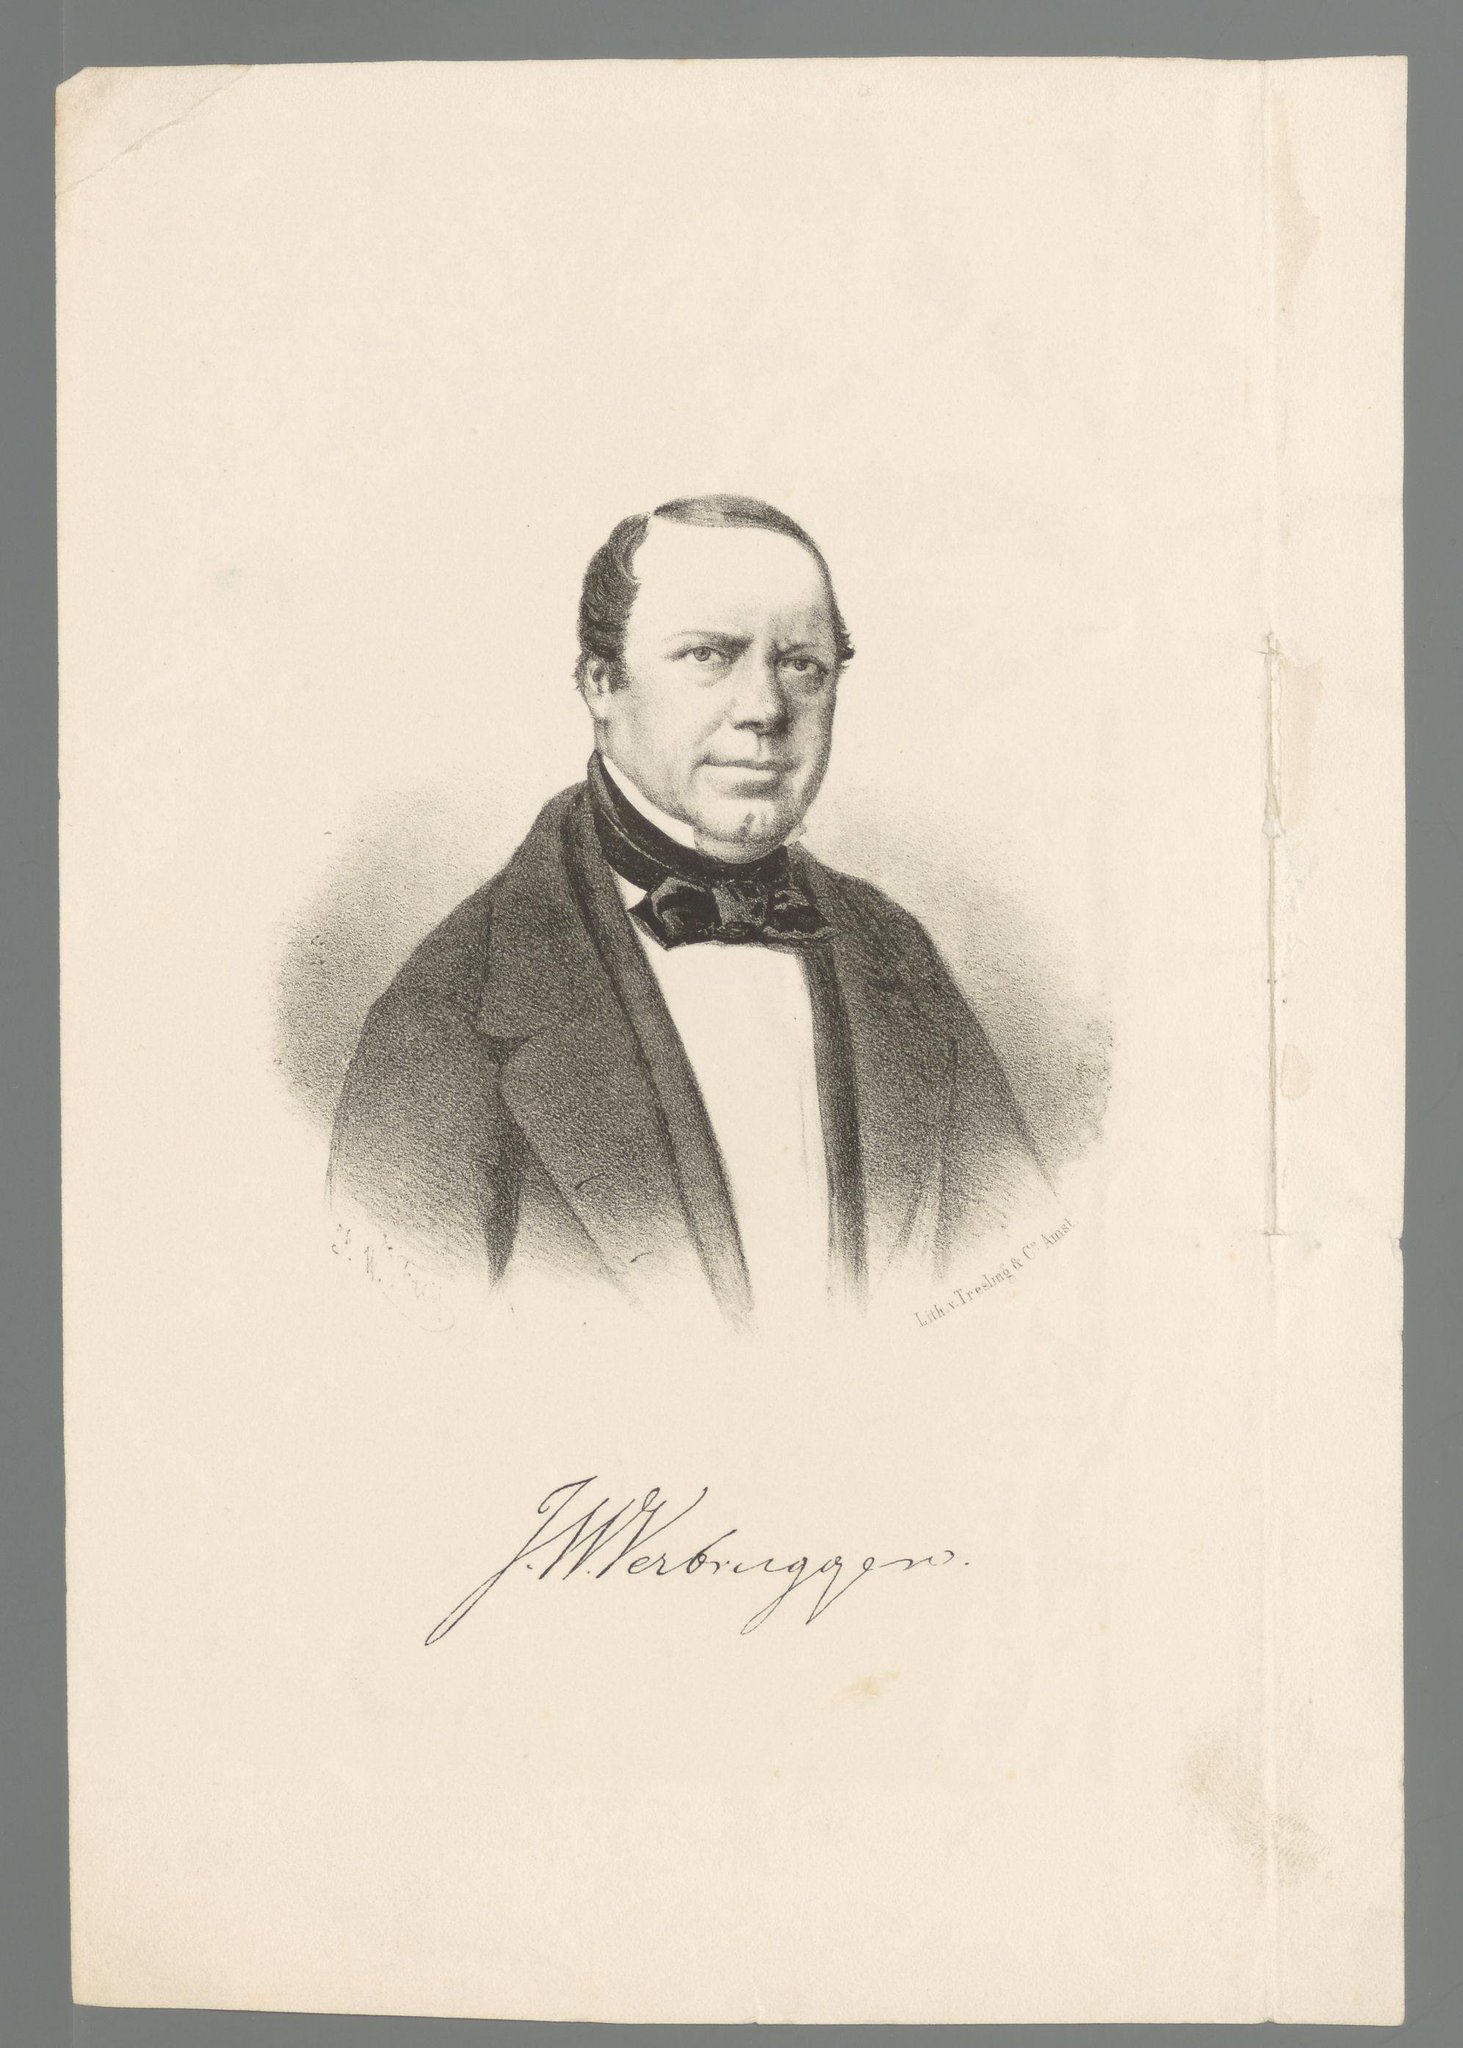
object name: print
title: Portret van J.W. Verbruggen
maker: johann wilhelm frey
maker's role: print maker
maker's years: 1830-1890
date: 1840-1890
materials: paper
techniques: lithograph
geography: amsterdam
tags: adult man, historical persons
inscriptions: collector's mark: Lugt 2228